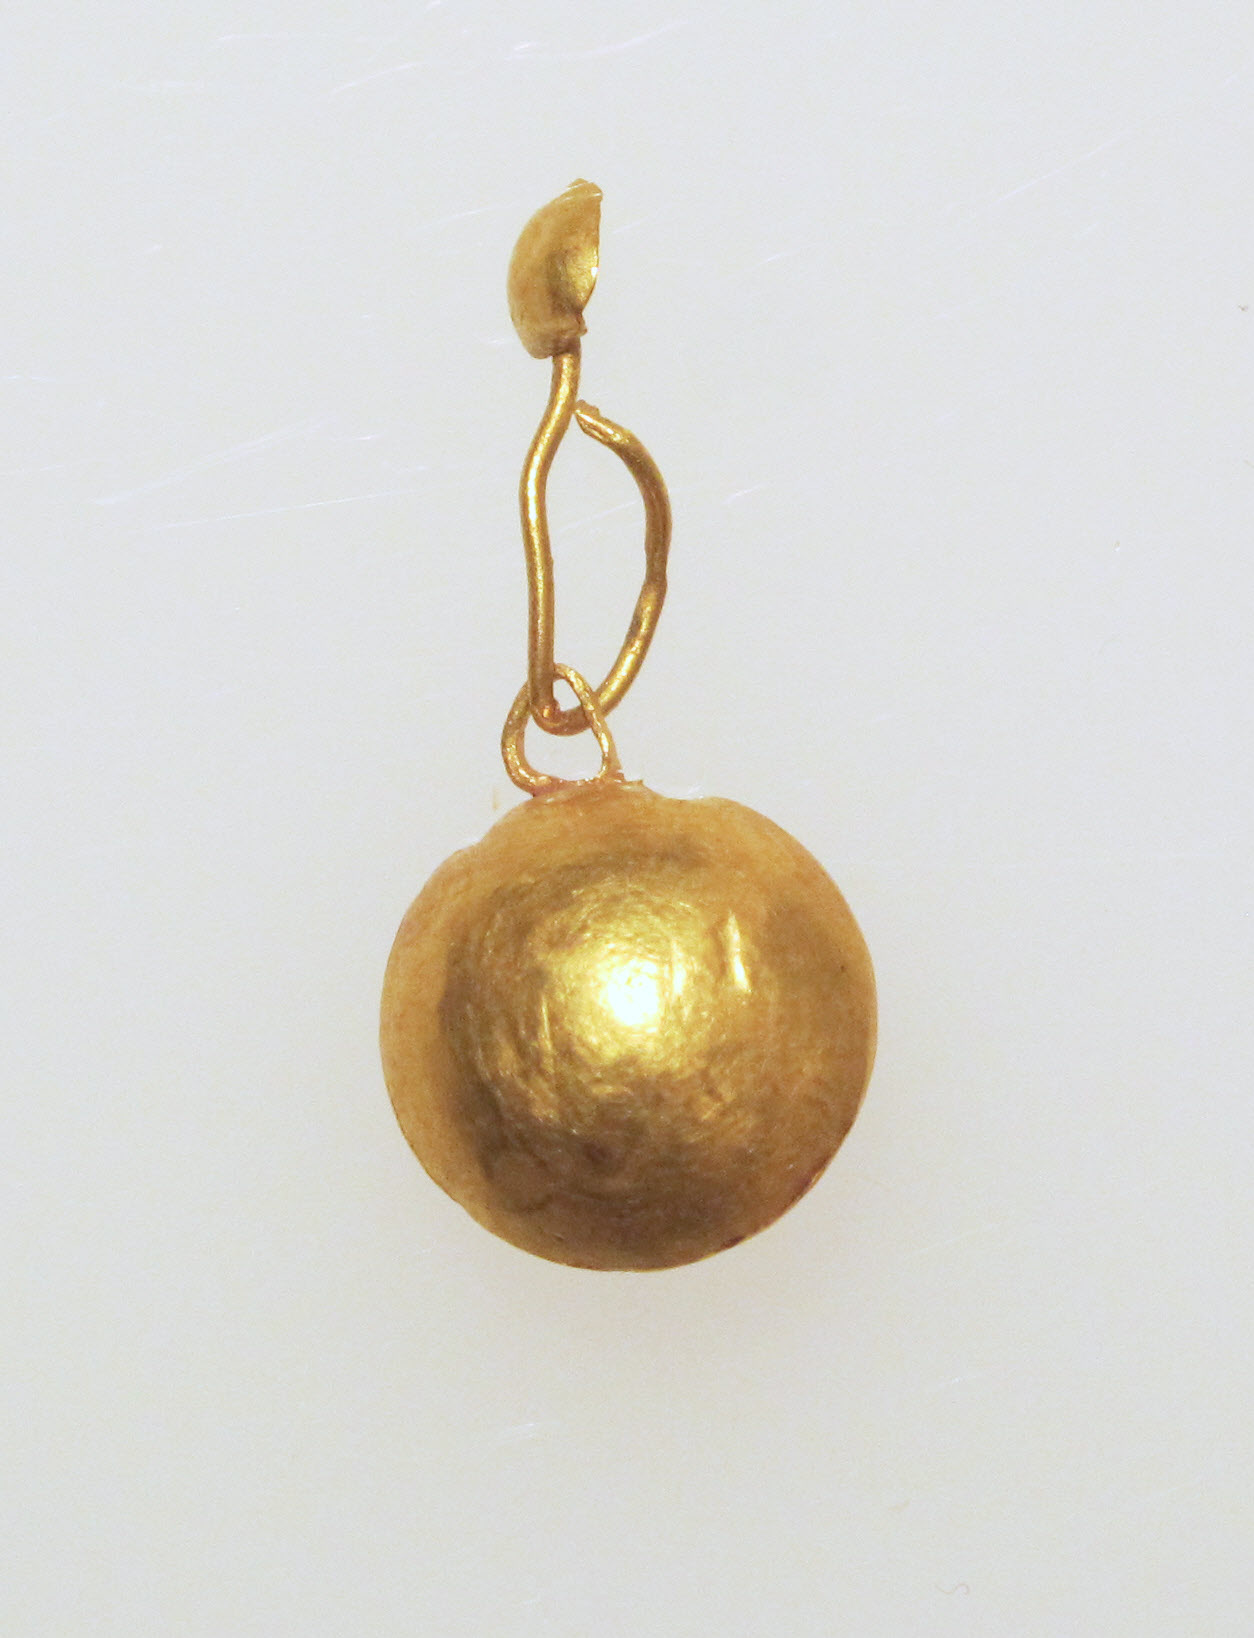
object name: earring with pendant and disc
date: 7000 BCE-330 CE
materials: gold